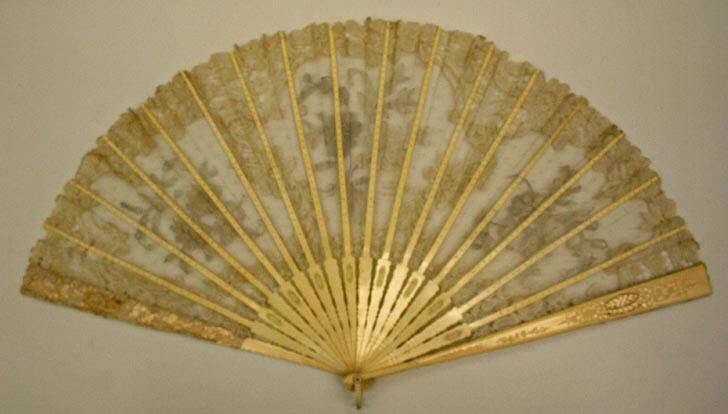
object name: fan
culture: french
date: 1898